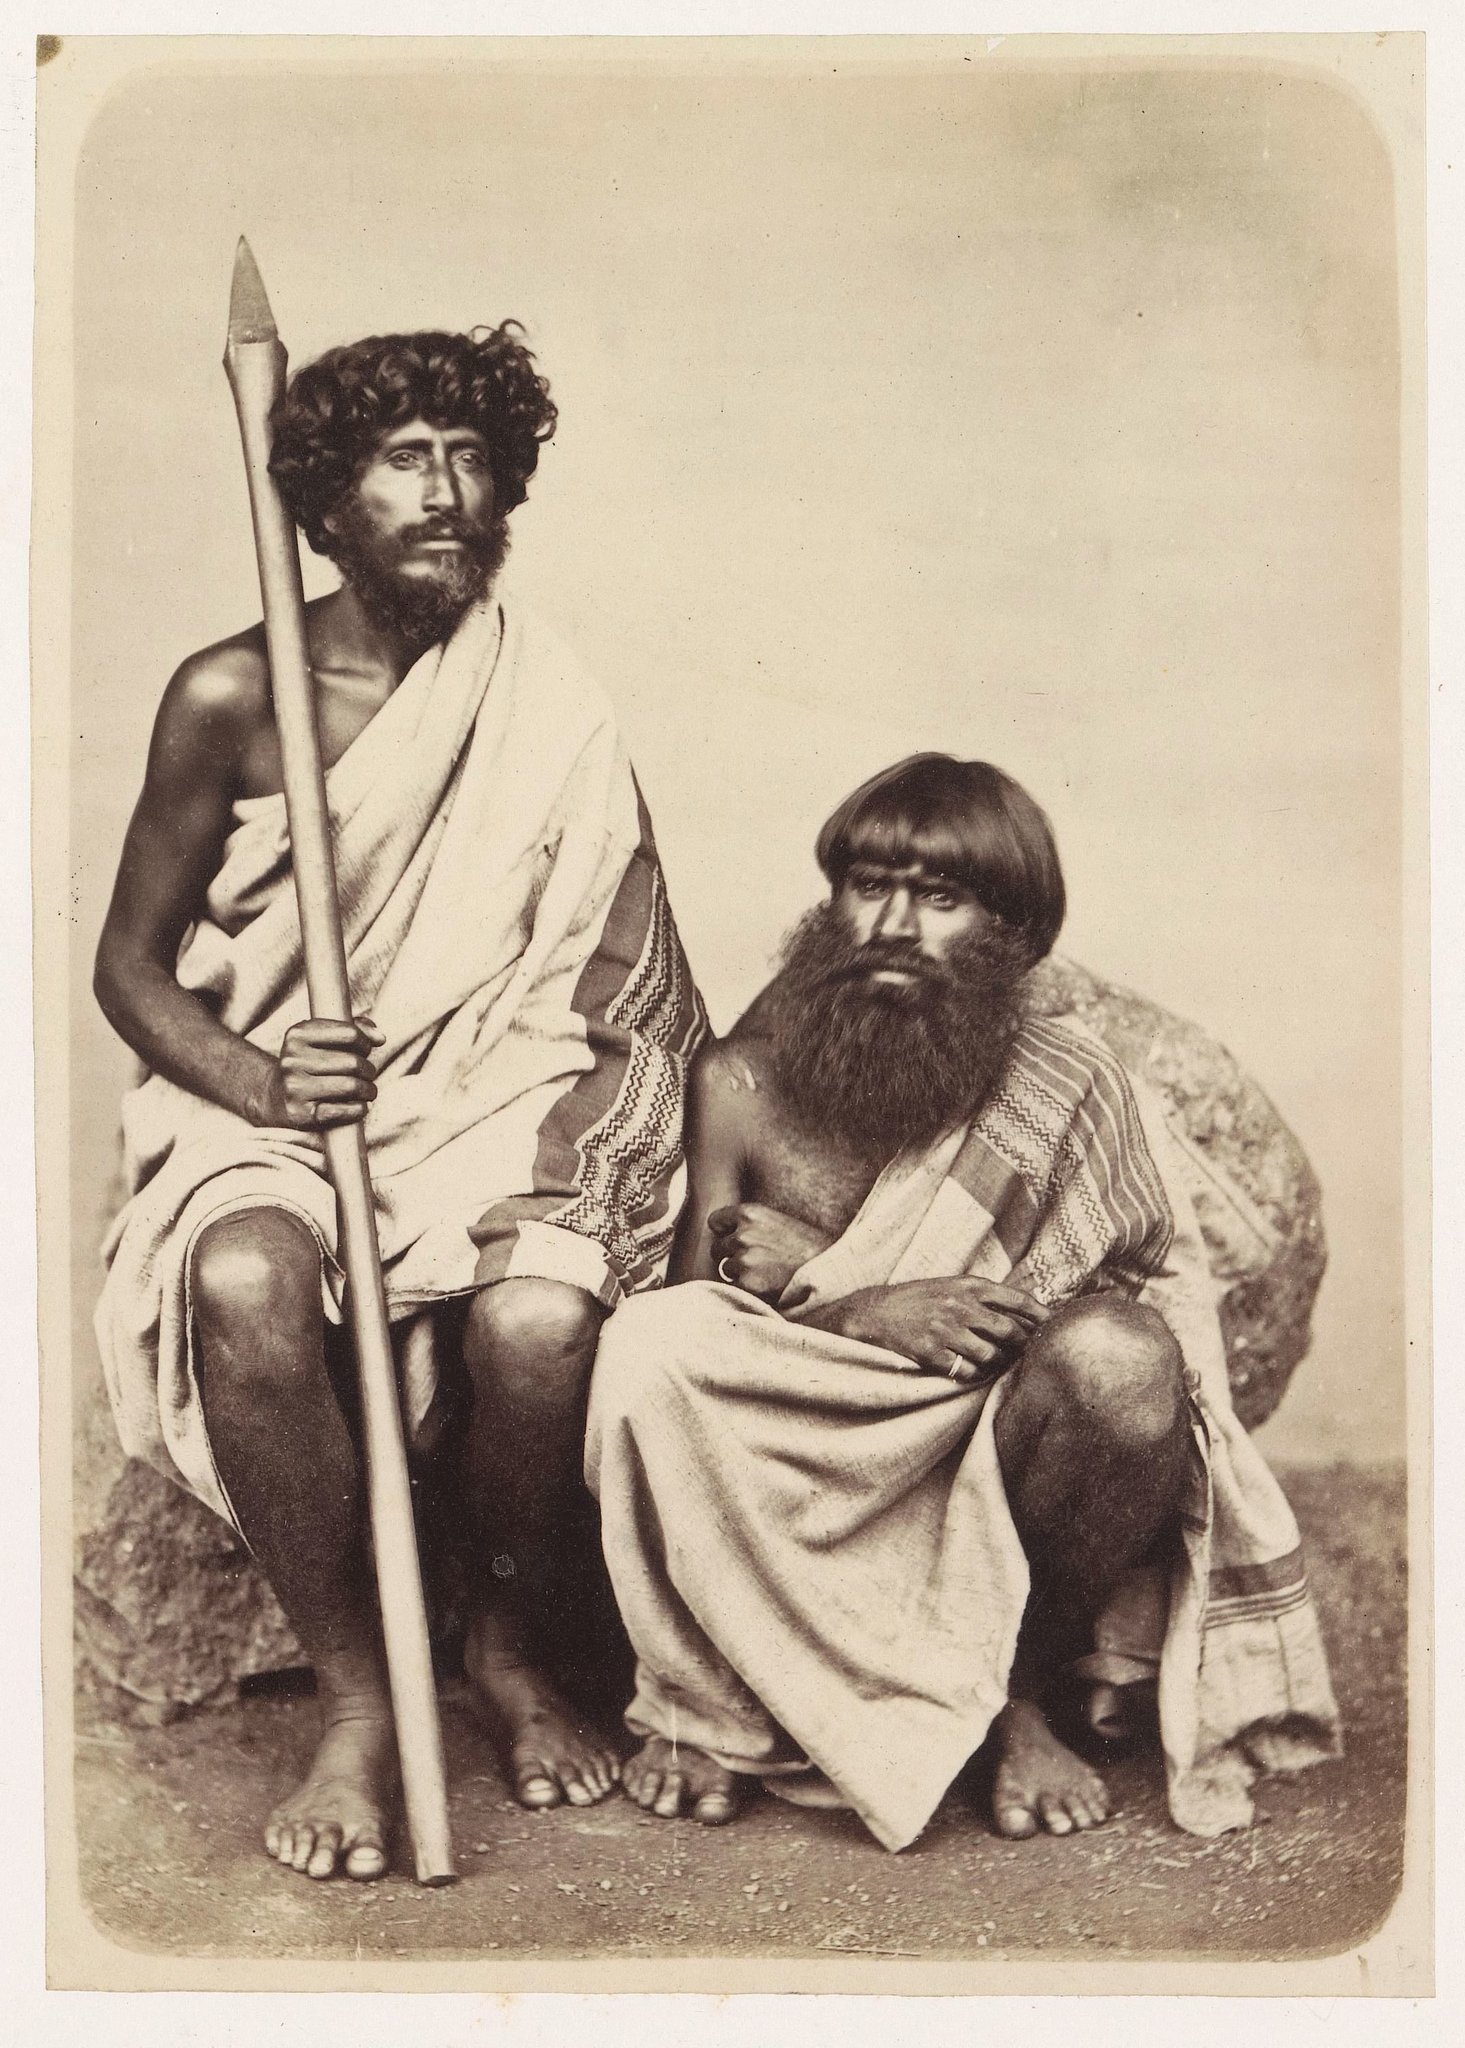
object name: photograph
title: Studio portrait of two unknown Toda men from the Nilgiri hills, Tamil Nadu, India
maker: a.t.w. penn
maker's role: fotograaf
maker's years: 1849-1924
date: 1860-1890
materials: cardboard, paper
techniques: albumen print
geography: tamil nadu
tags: adult man, anonymous historical person portrayed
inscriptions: title: ‘Aboriginal Tribes/ Neilgherry Hills.’